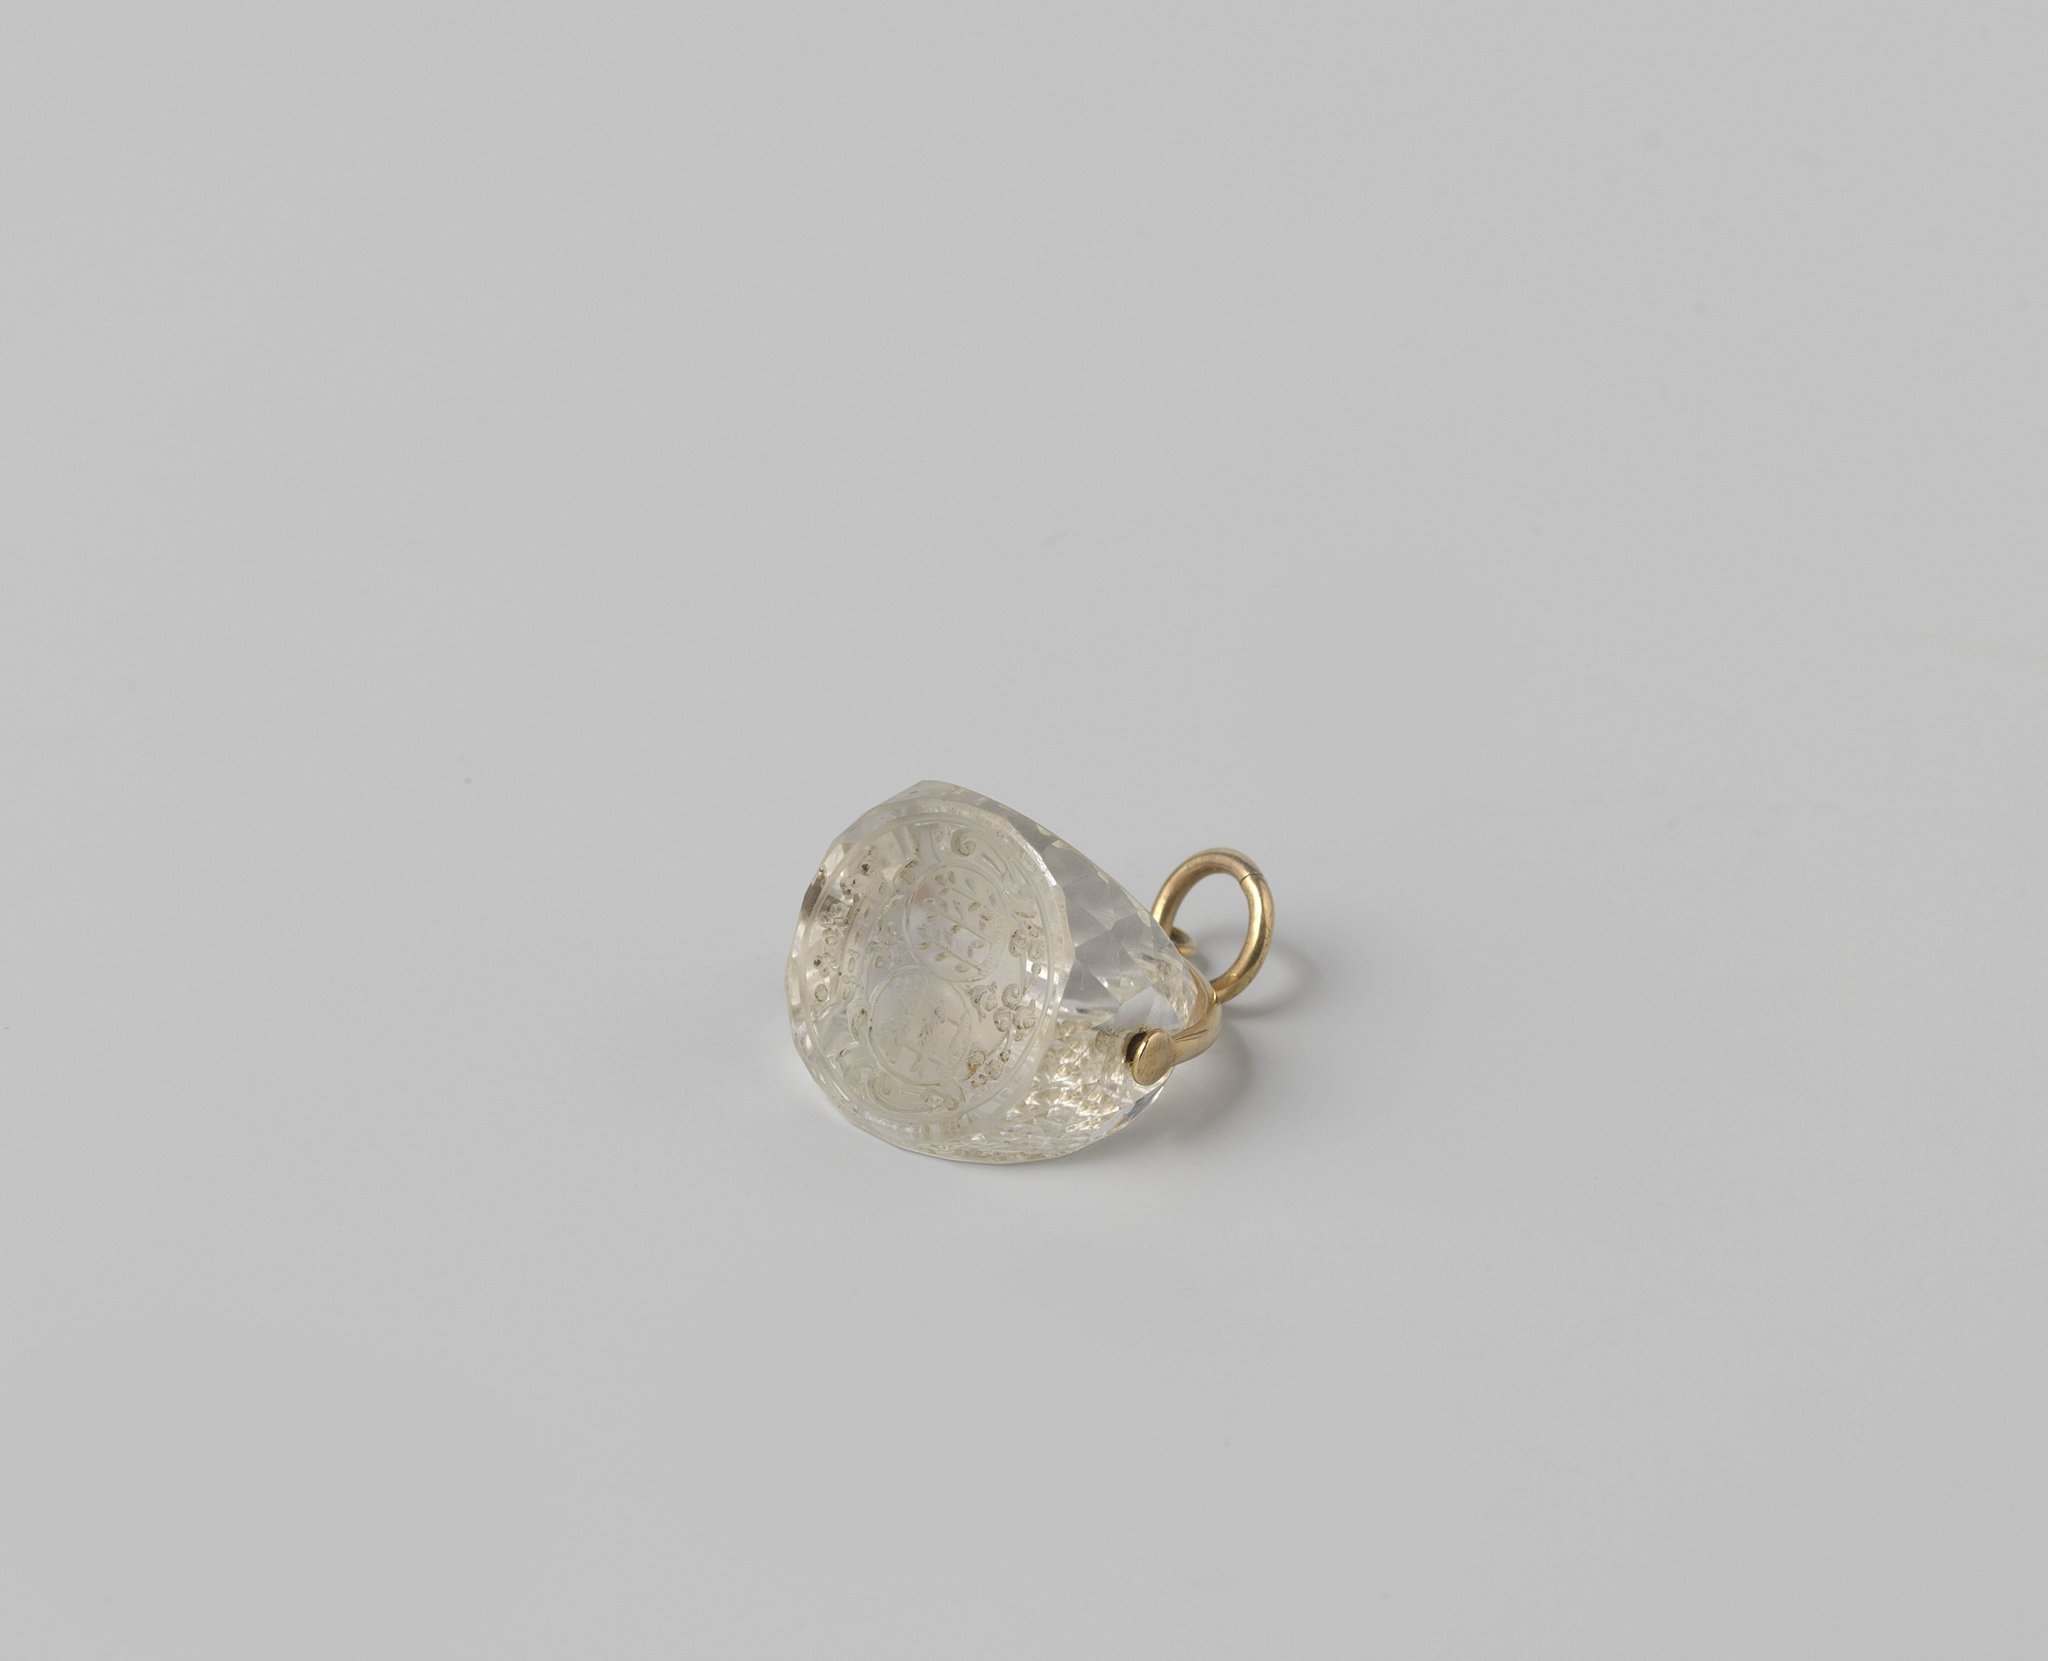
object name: pendant jewelry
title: Cachet met de wapens van Gerard Johan Vreelandt en Petronella Visboom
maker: Anonymous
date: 1740-1750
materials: gold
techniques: cutting, forging, grinding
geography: colombo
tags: sri lanka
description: Aan de gouden bengeltje met draagoog en draagring hangt een geslepen berkristal. Aan drie zijden is in de steen een ronde stempel ingesneden met een wapenschild: twee maal een verschillend wapen, de derde een combinatie van de eerste twee. De steen is zo aan de gouden hanger bevestigd, dat zij om haar as kan draaien en er met de drie stempels afzonderlijk gestempeld kan worden.